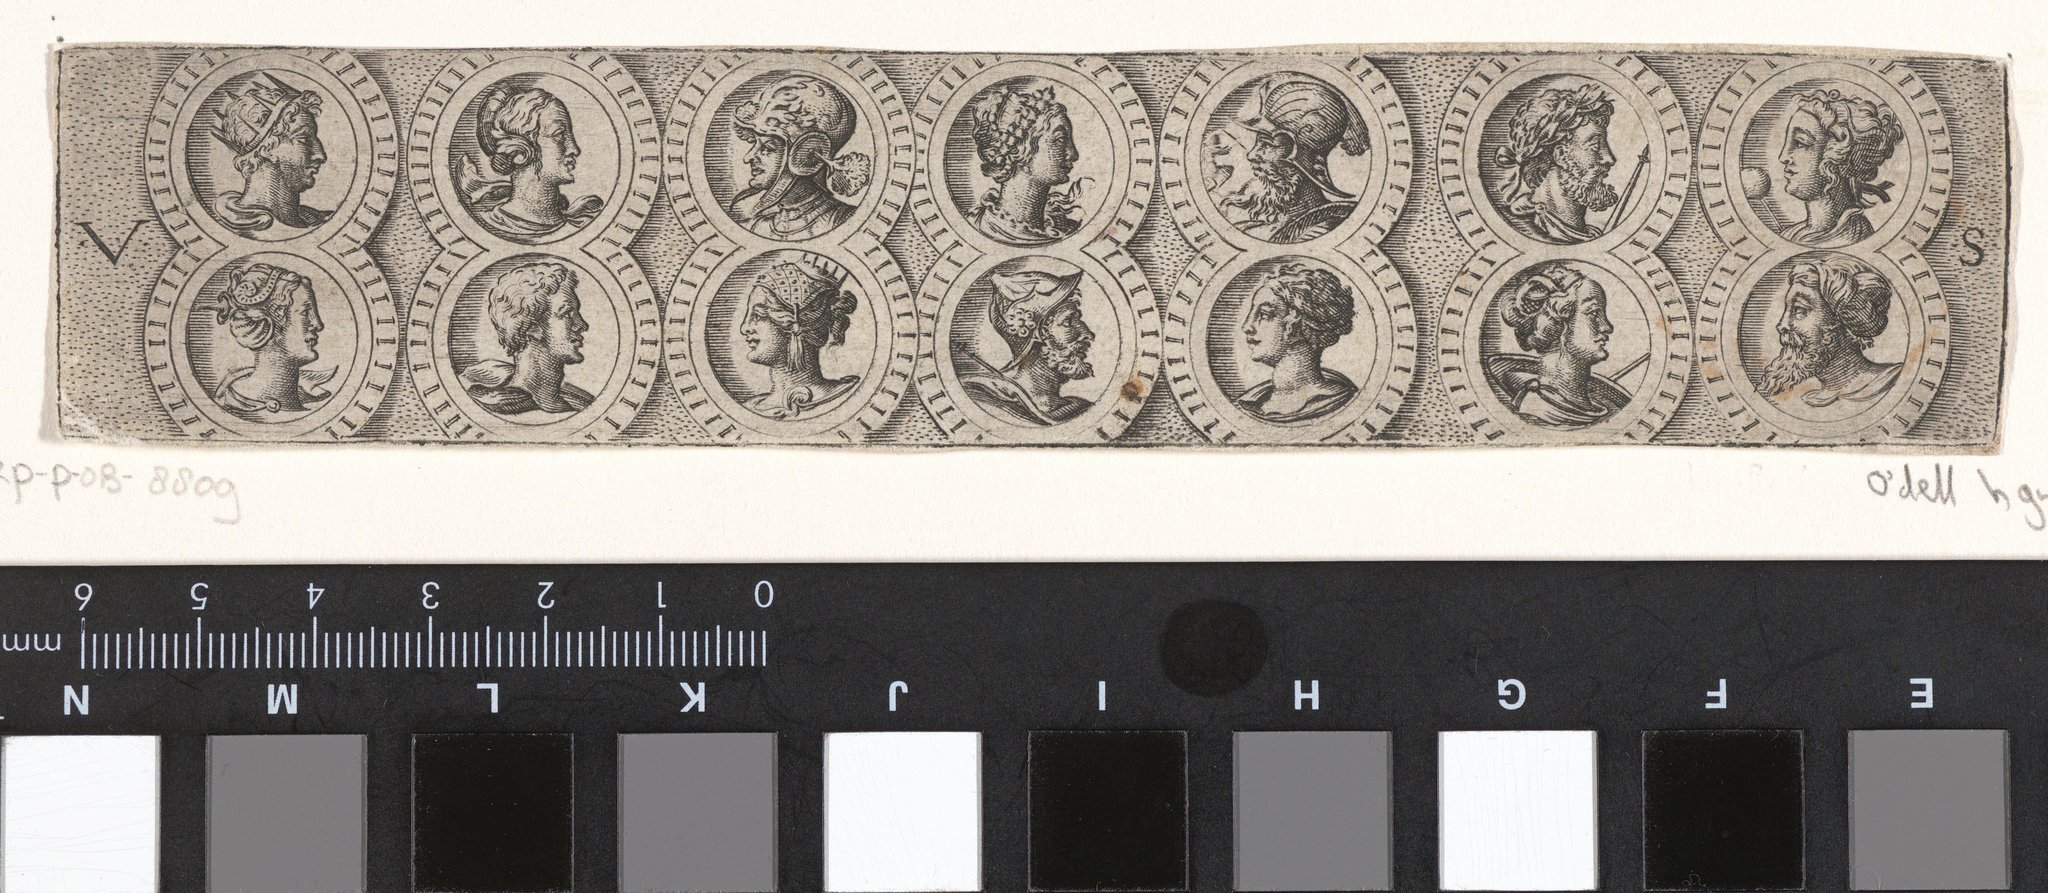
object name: print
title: Fries met veertien koppen in medaillons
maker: virgilius solis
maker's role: draughtsman, print maker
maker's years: 1514-1562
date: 1524-1562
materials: paper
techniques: engraving